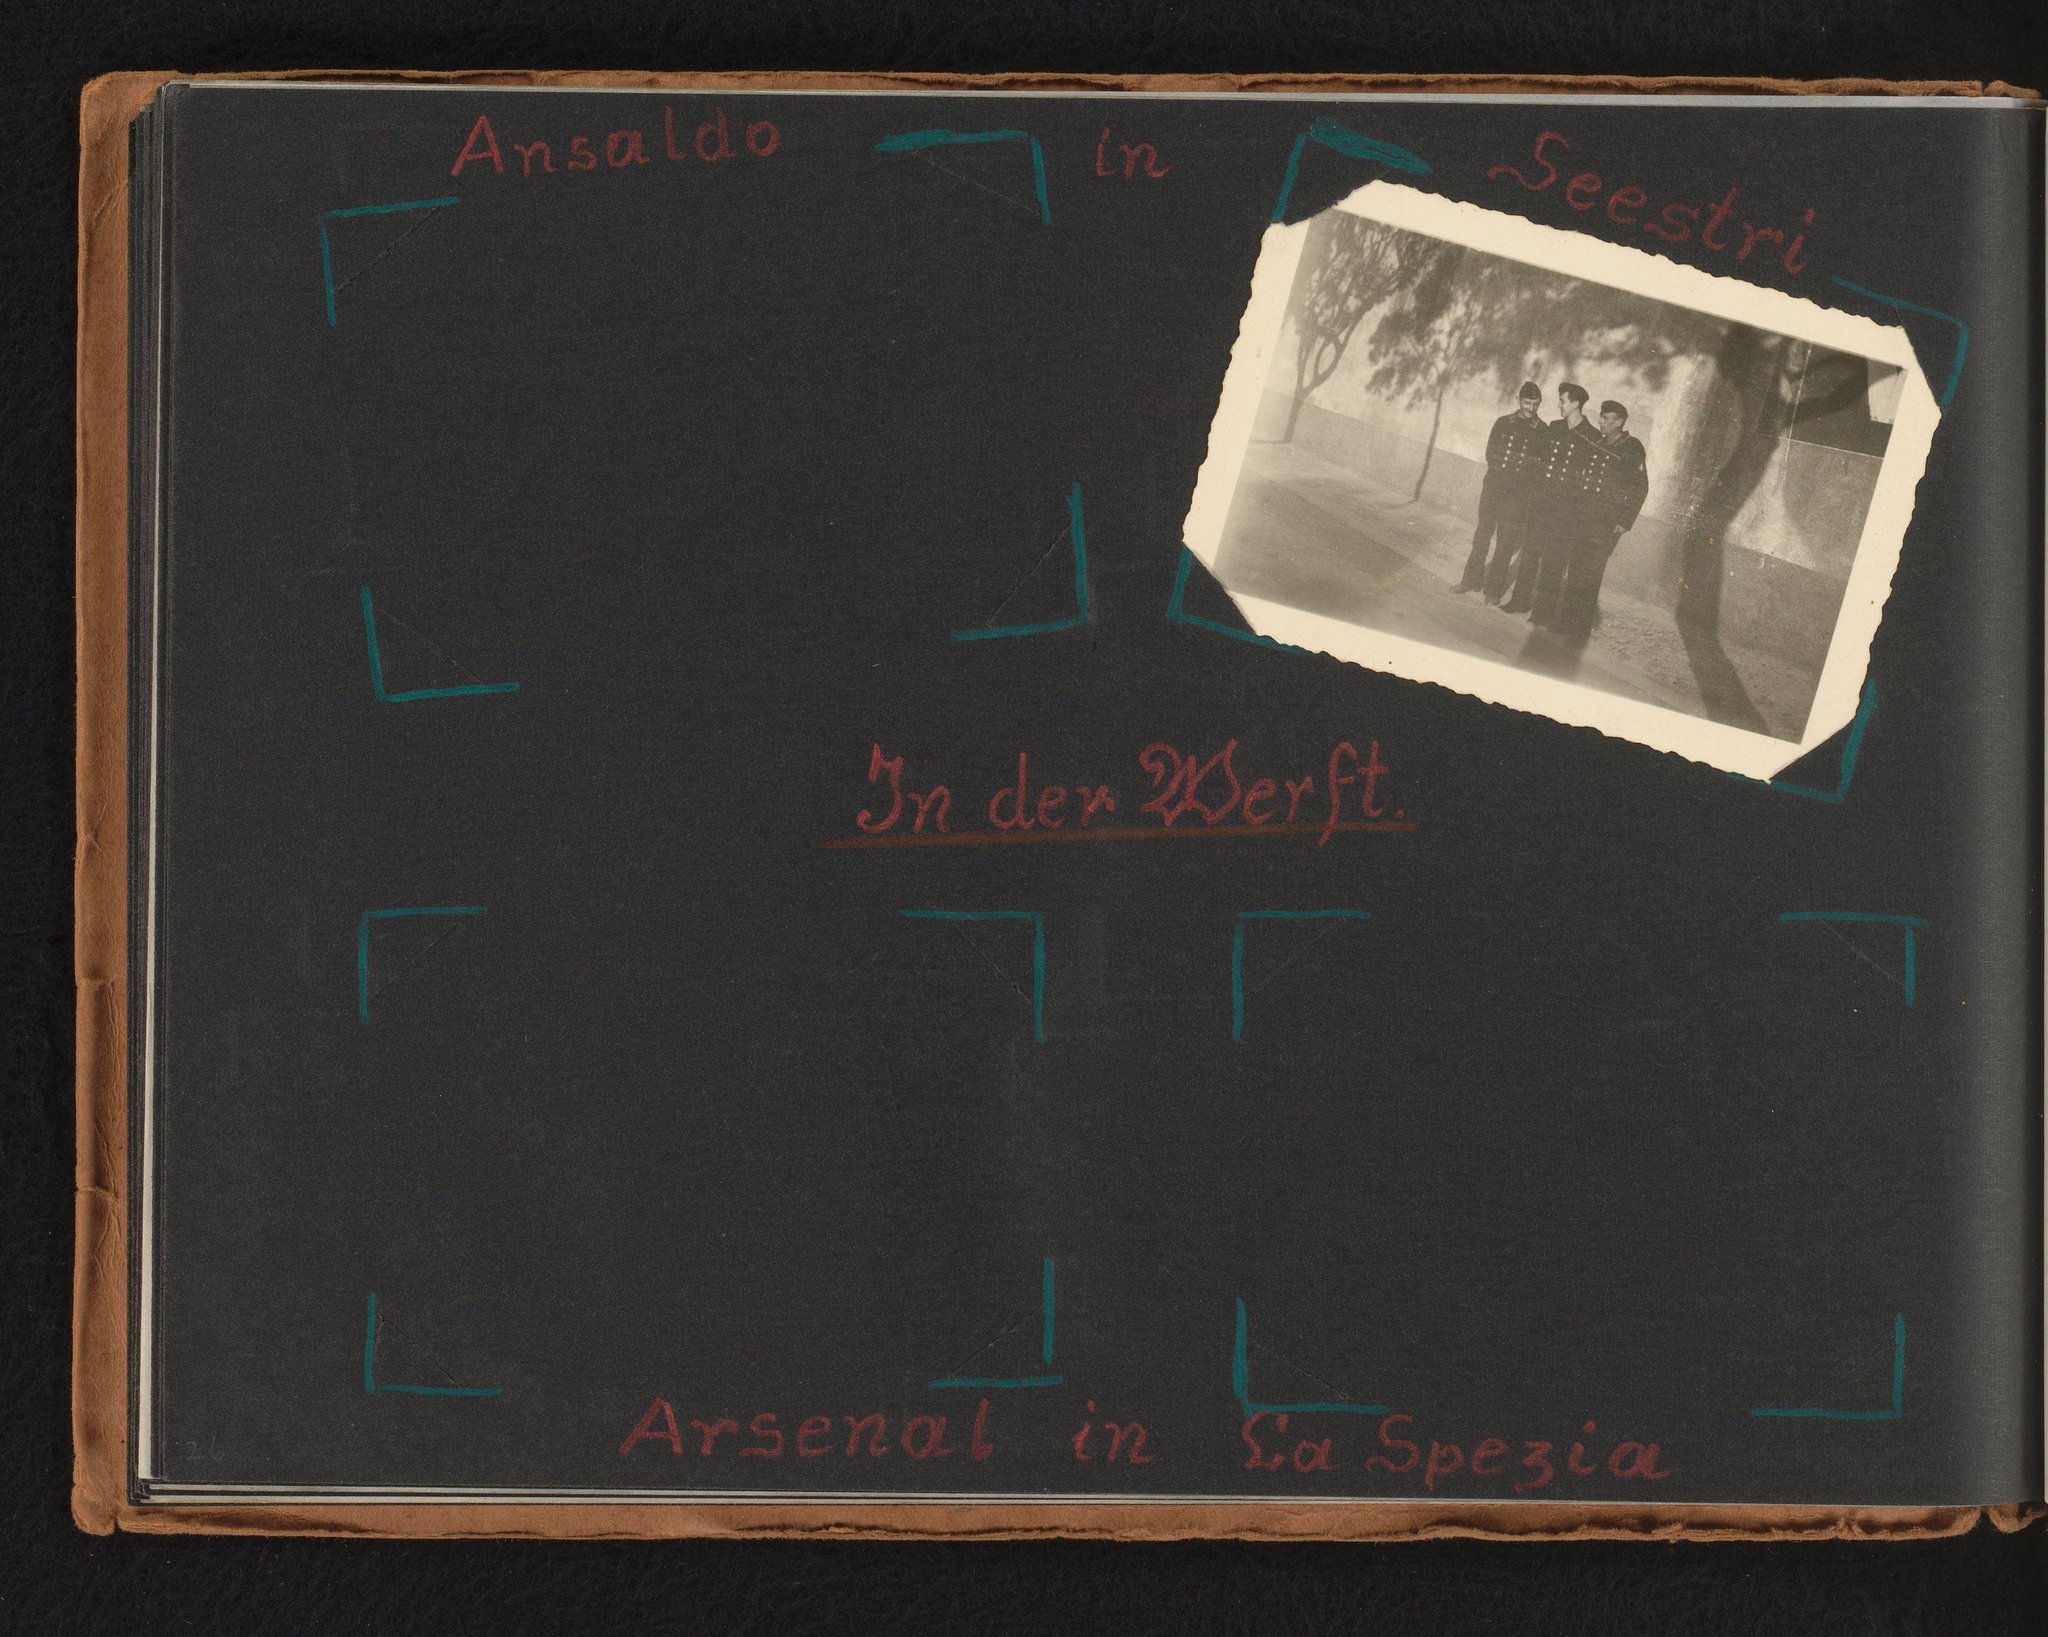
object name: photograph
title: Sestri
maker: Anonymous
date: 1943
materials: paper, photographic support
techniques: gelatin silver print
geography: italy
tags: werner neufang, the company, the unit, the troop ~ military service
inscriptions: inscription: ‘Lemke u. Schiller / Sestri 1943’, inscription: ‘In der Werft. / Ansaldo in Seestri / ...’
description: Albumblad een foto van Werner tijdens zijn stationering in Sestri, bij Genua in Italië, 1943. De overige drie foto's die oorspronkelijk op dit blad zaten ingestoken ontbreken. Onderdeel van een fotoalbum over de Duitse Werner Neufang van de Kriegsmarine en de Nederlandse Thea Driesen.